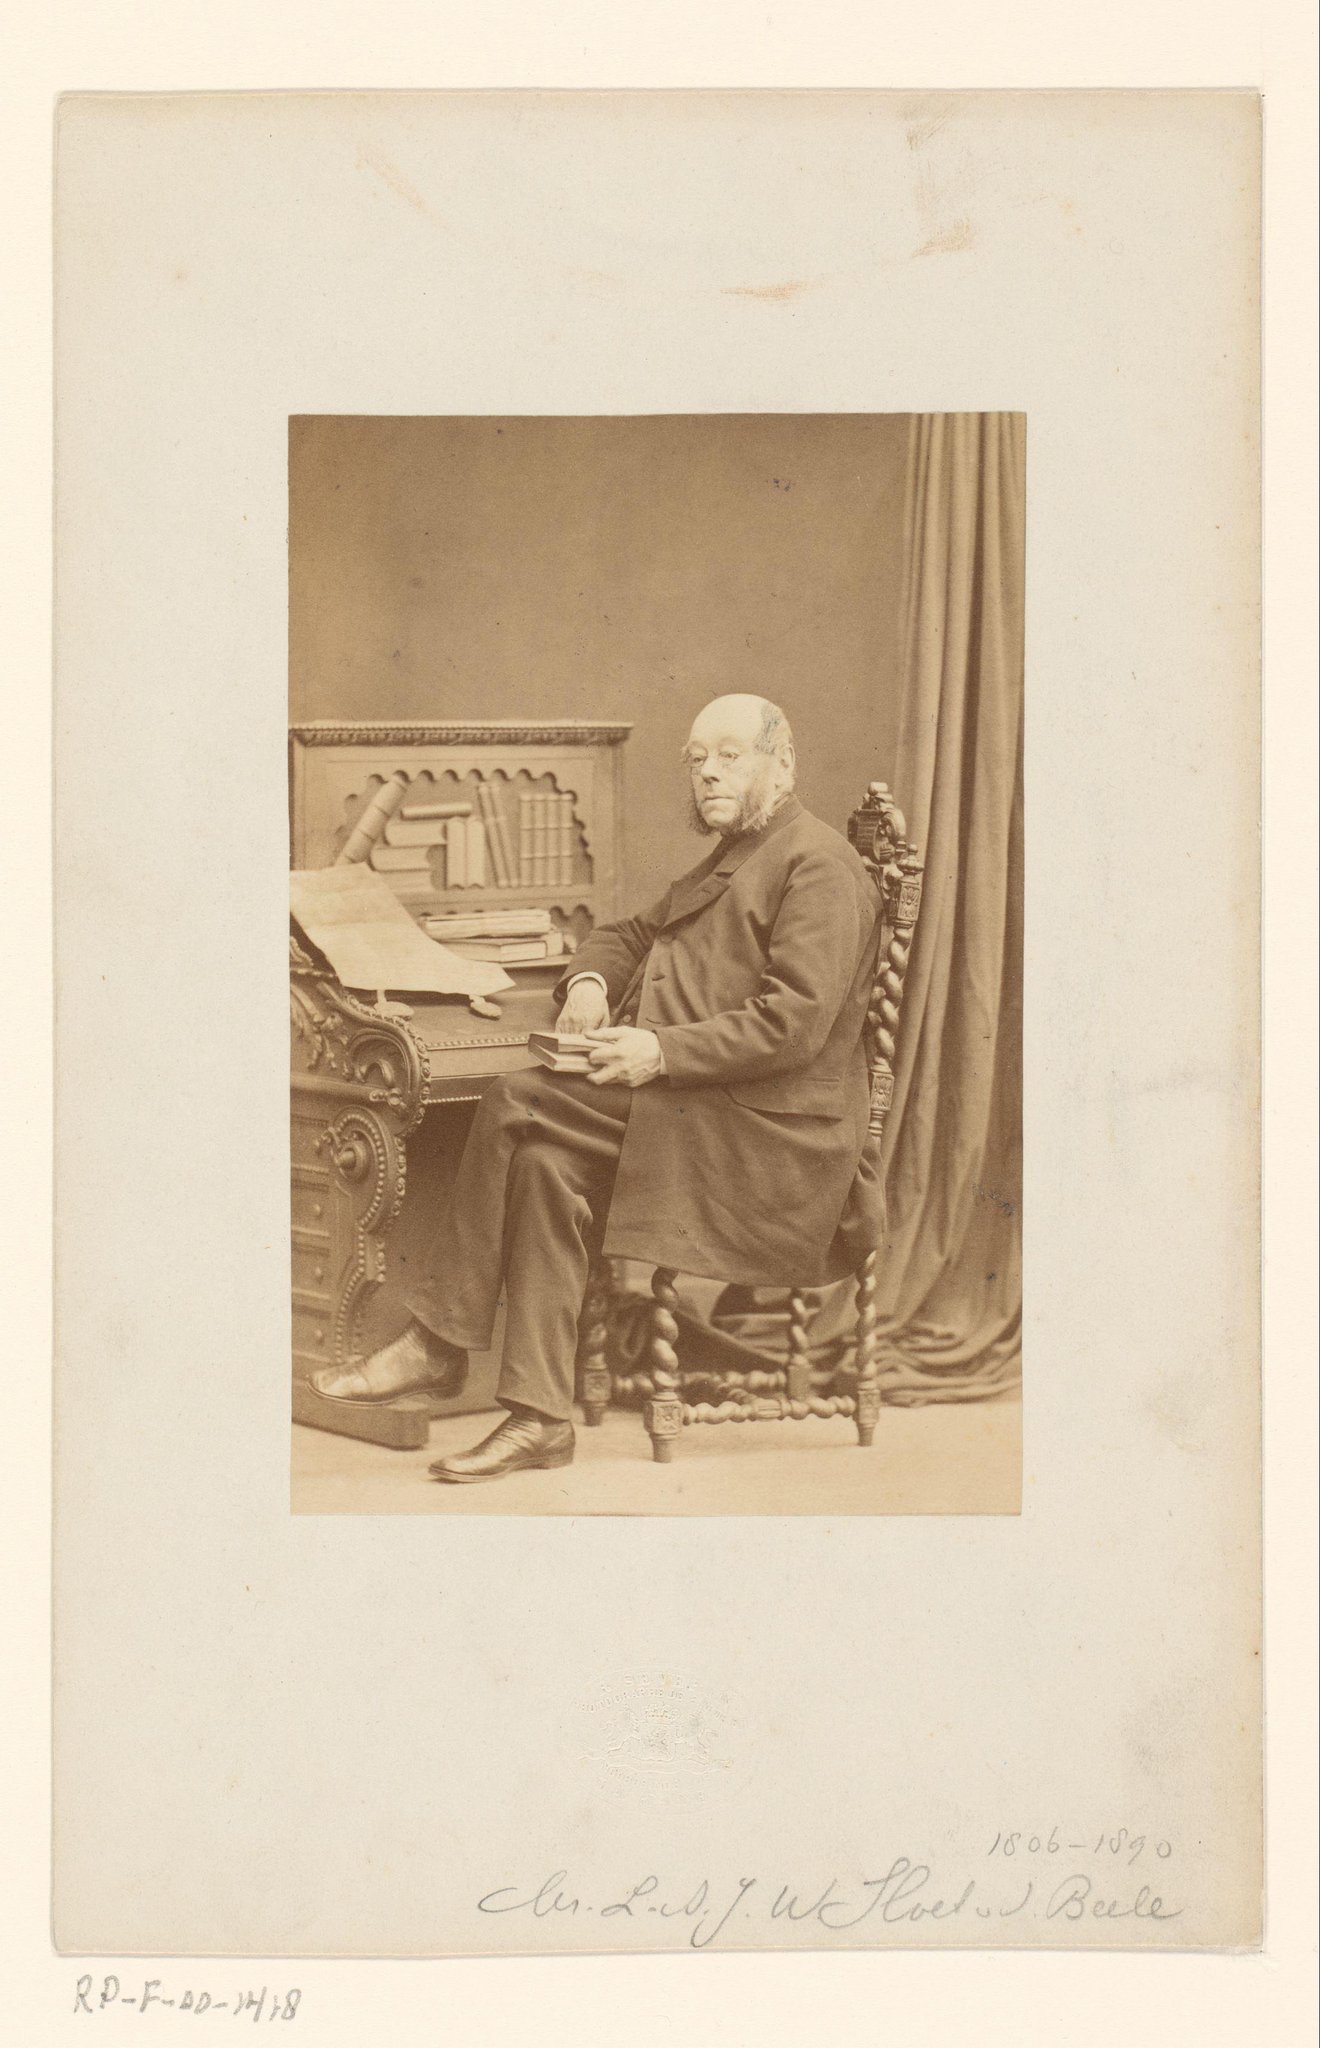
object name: photograph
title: Portret van L.A.J.W. baron Sloet van de Beele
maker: robert severin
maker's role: fotograaf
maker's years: 1839-1888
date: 1860-1875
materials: cardboard, paper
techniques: albumen print, retouching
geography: the hague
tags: arnhem, politician, writing-table, writing-desk, historical persons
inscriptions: check stamp: ‘R. Severin/ Photographe de S.M. le Roi/ Noordeinde 109/ La Haye’, inscription: ‘Baron Sloet vd Beele’, inscription: ‘1806-1890/ Mr. L.A.J.W. Sloet v.d. Beele’